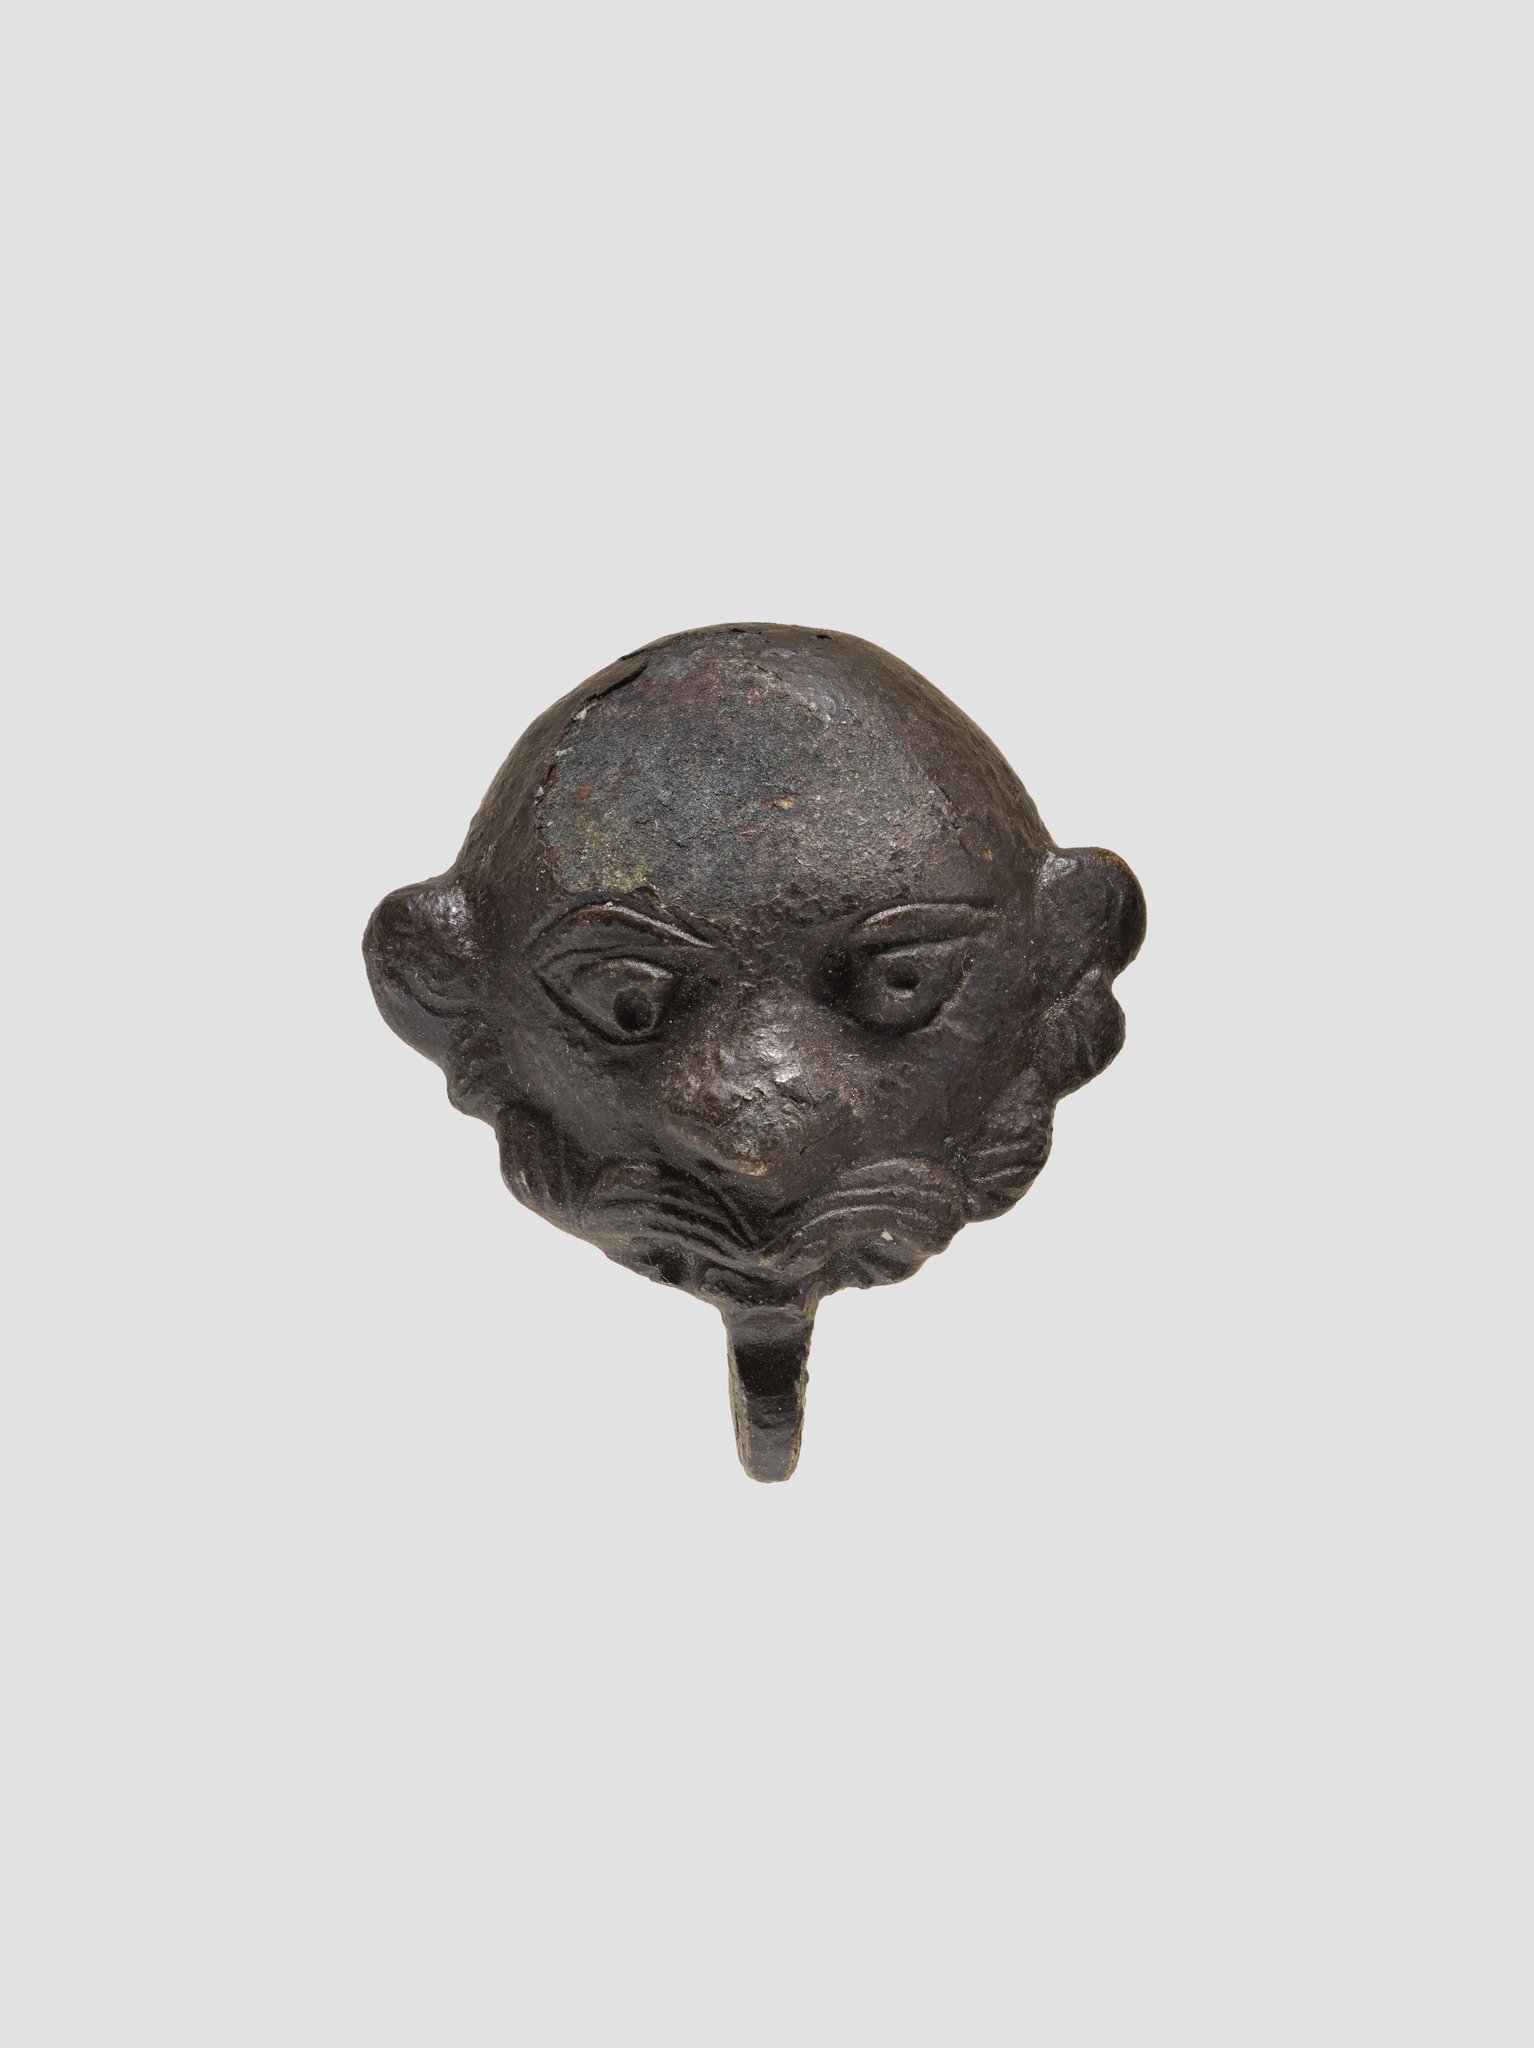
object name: cover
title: Cover in the form of a man's head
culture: sasanian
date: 201-700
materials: bronze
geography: iran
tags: heads,men